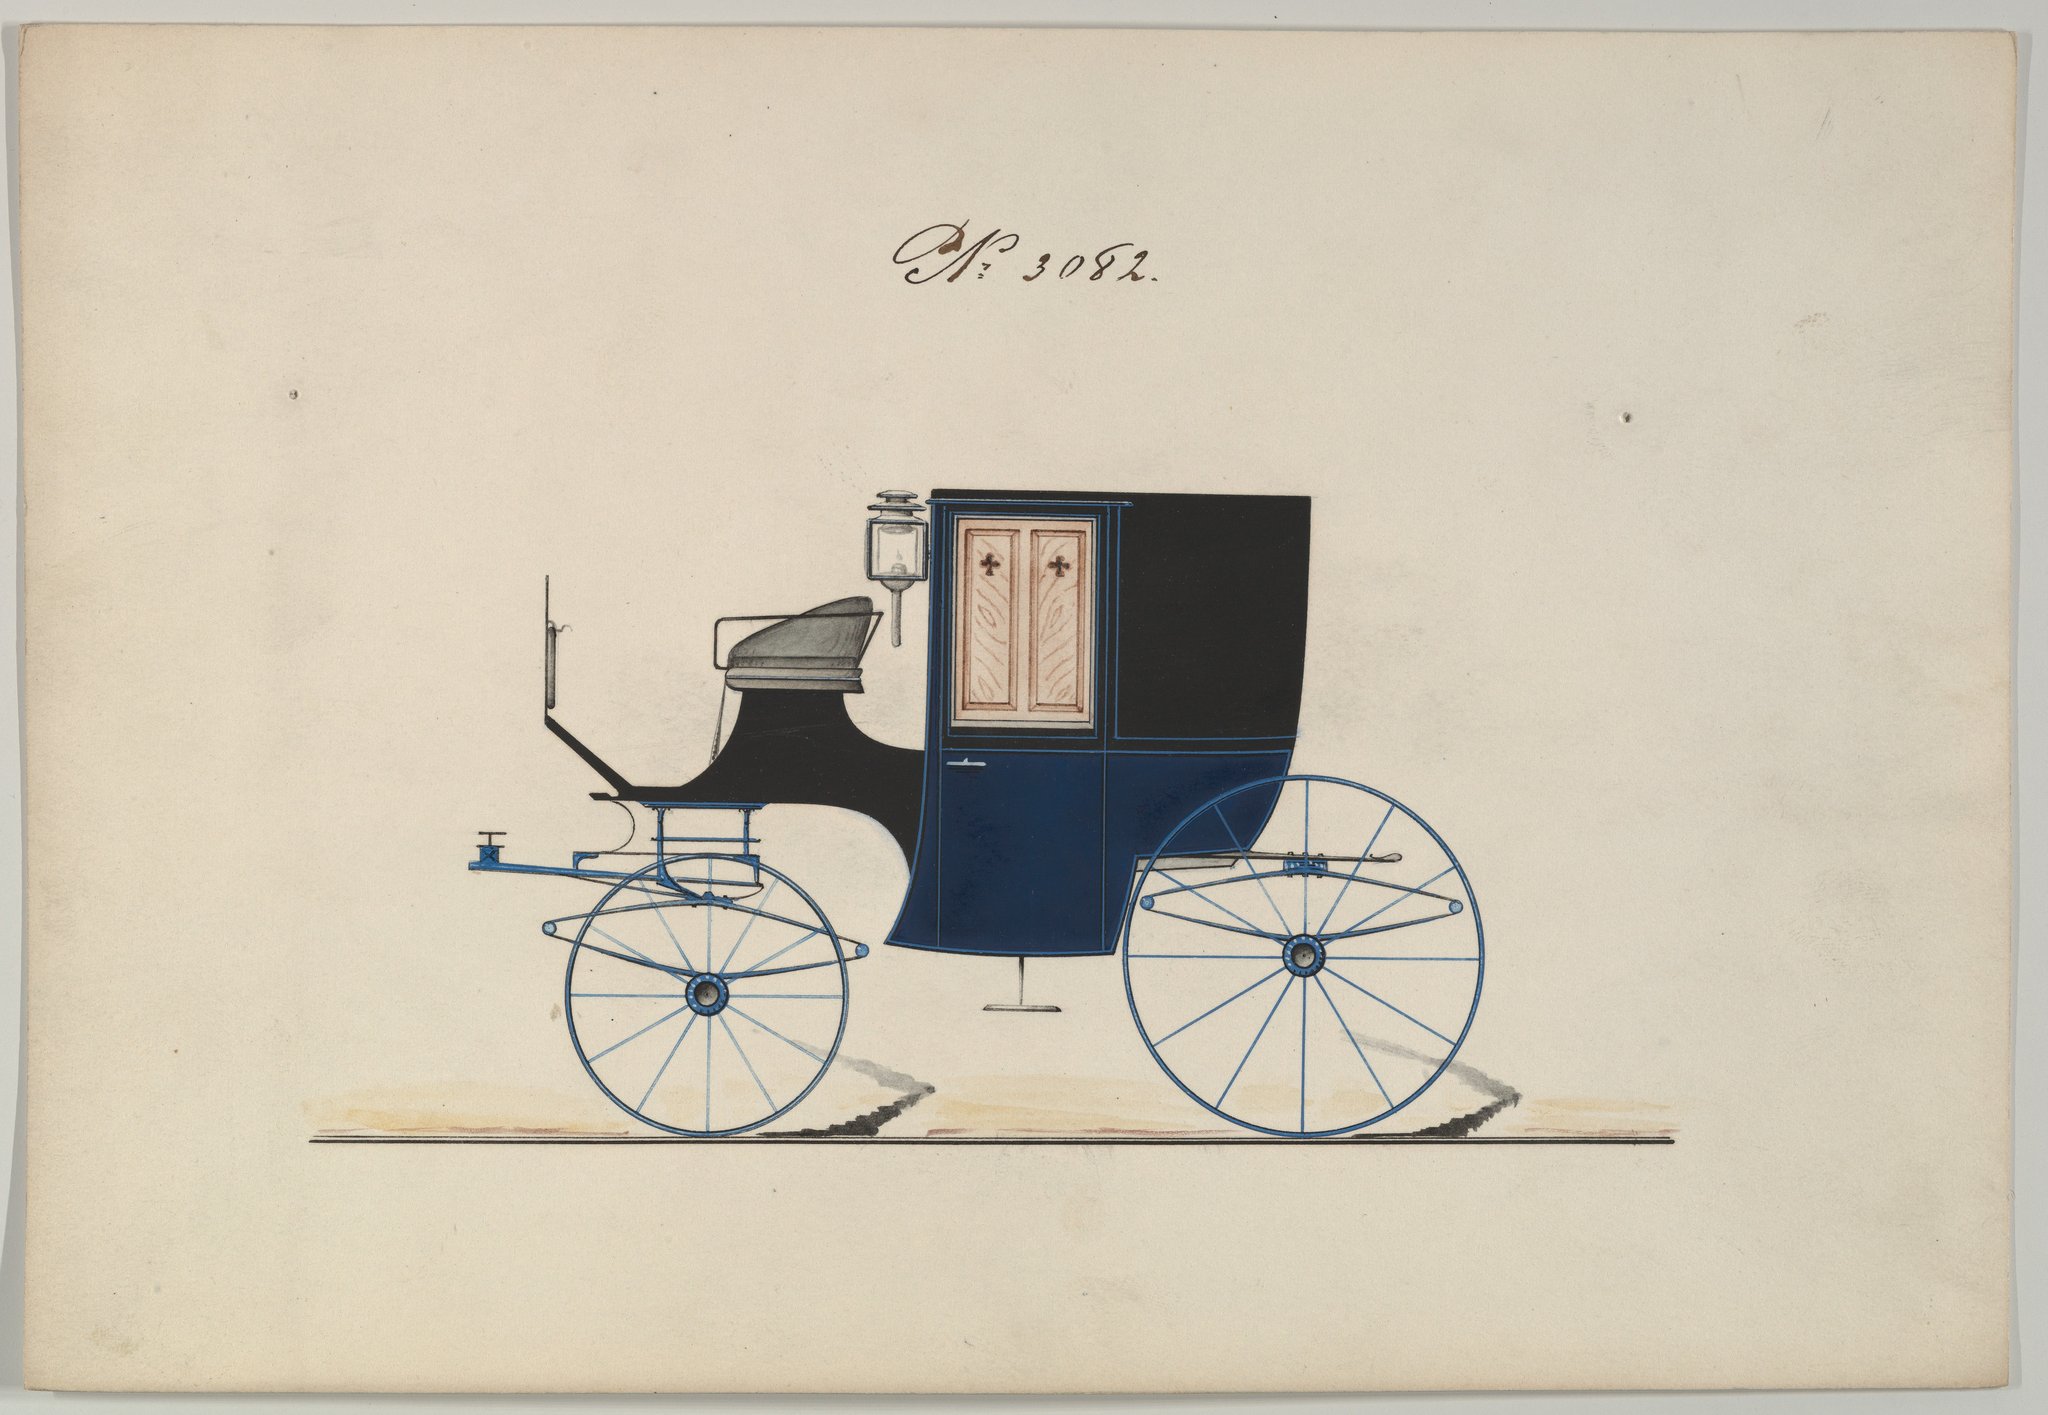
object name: drawing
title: Brougham #3082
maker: brewster & co.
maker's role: manufacturer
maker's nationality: american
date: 1874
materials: gouache, ink, watercolor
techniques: pen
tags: carriages